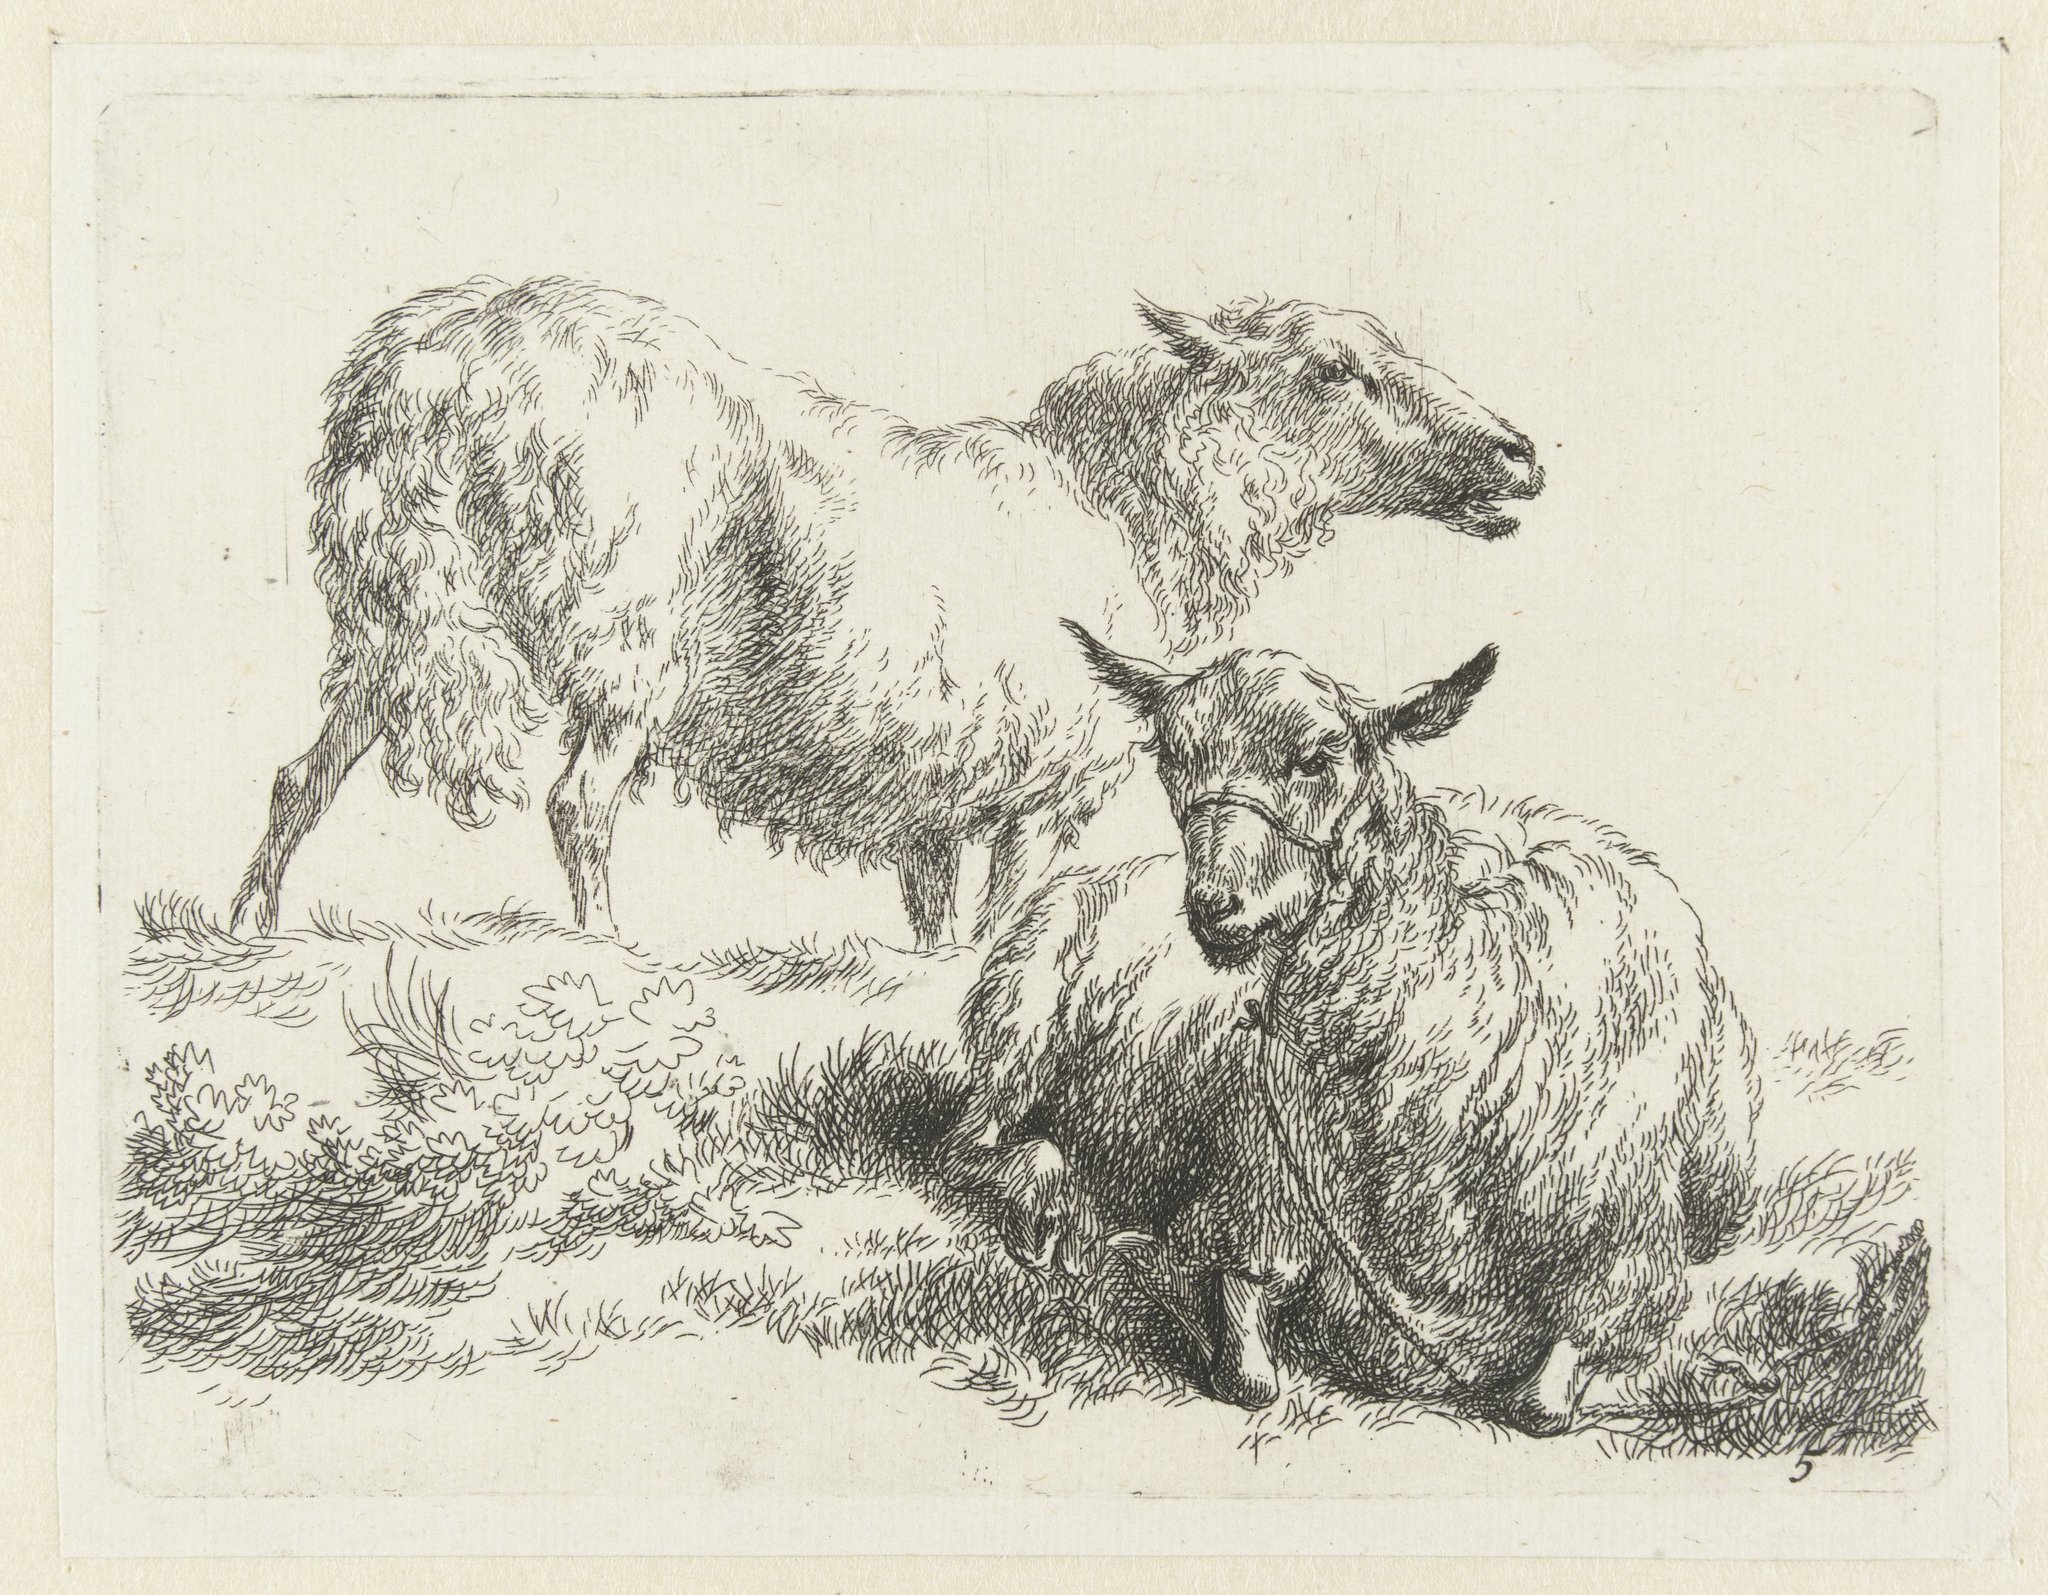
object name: print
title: Schapen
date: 1648-1652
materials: paper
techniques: etching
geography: netherlands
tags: sheep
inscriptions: collector's mark: Lugt 240